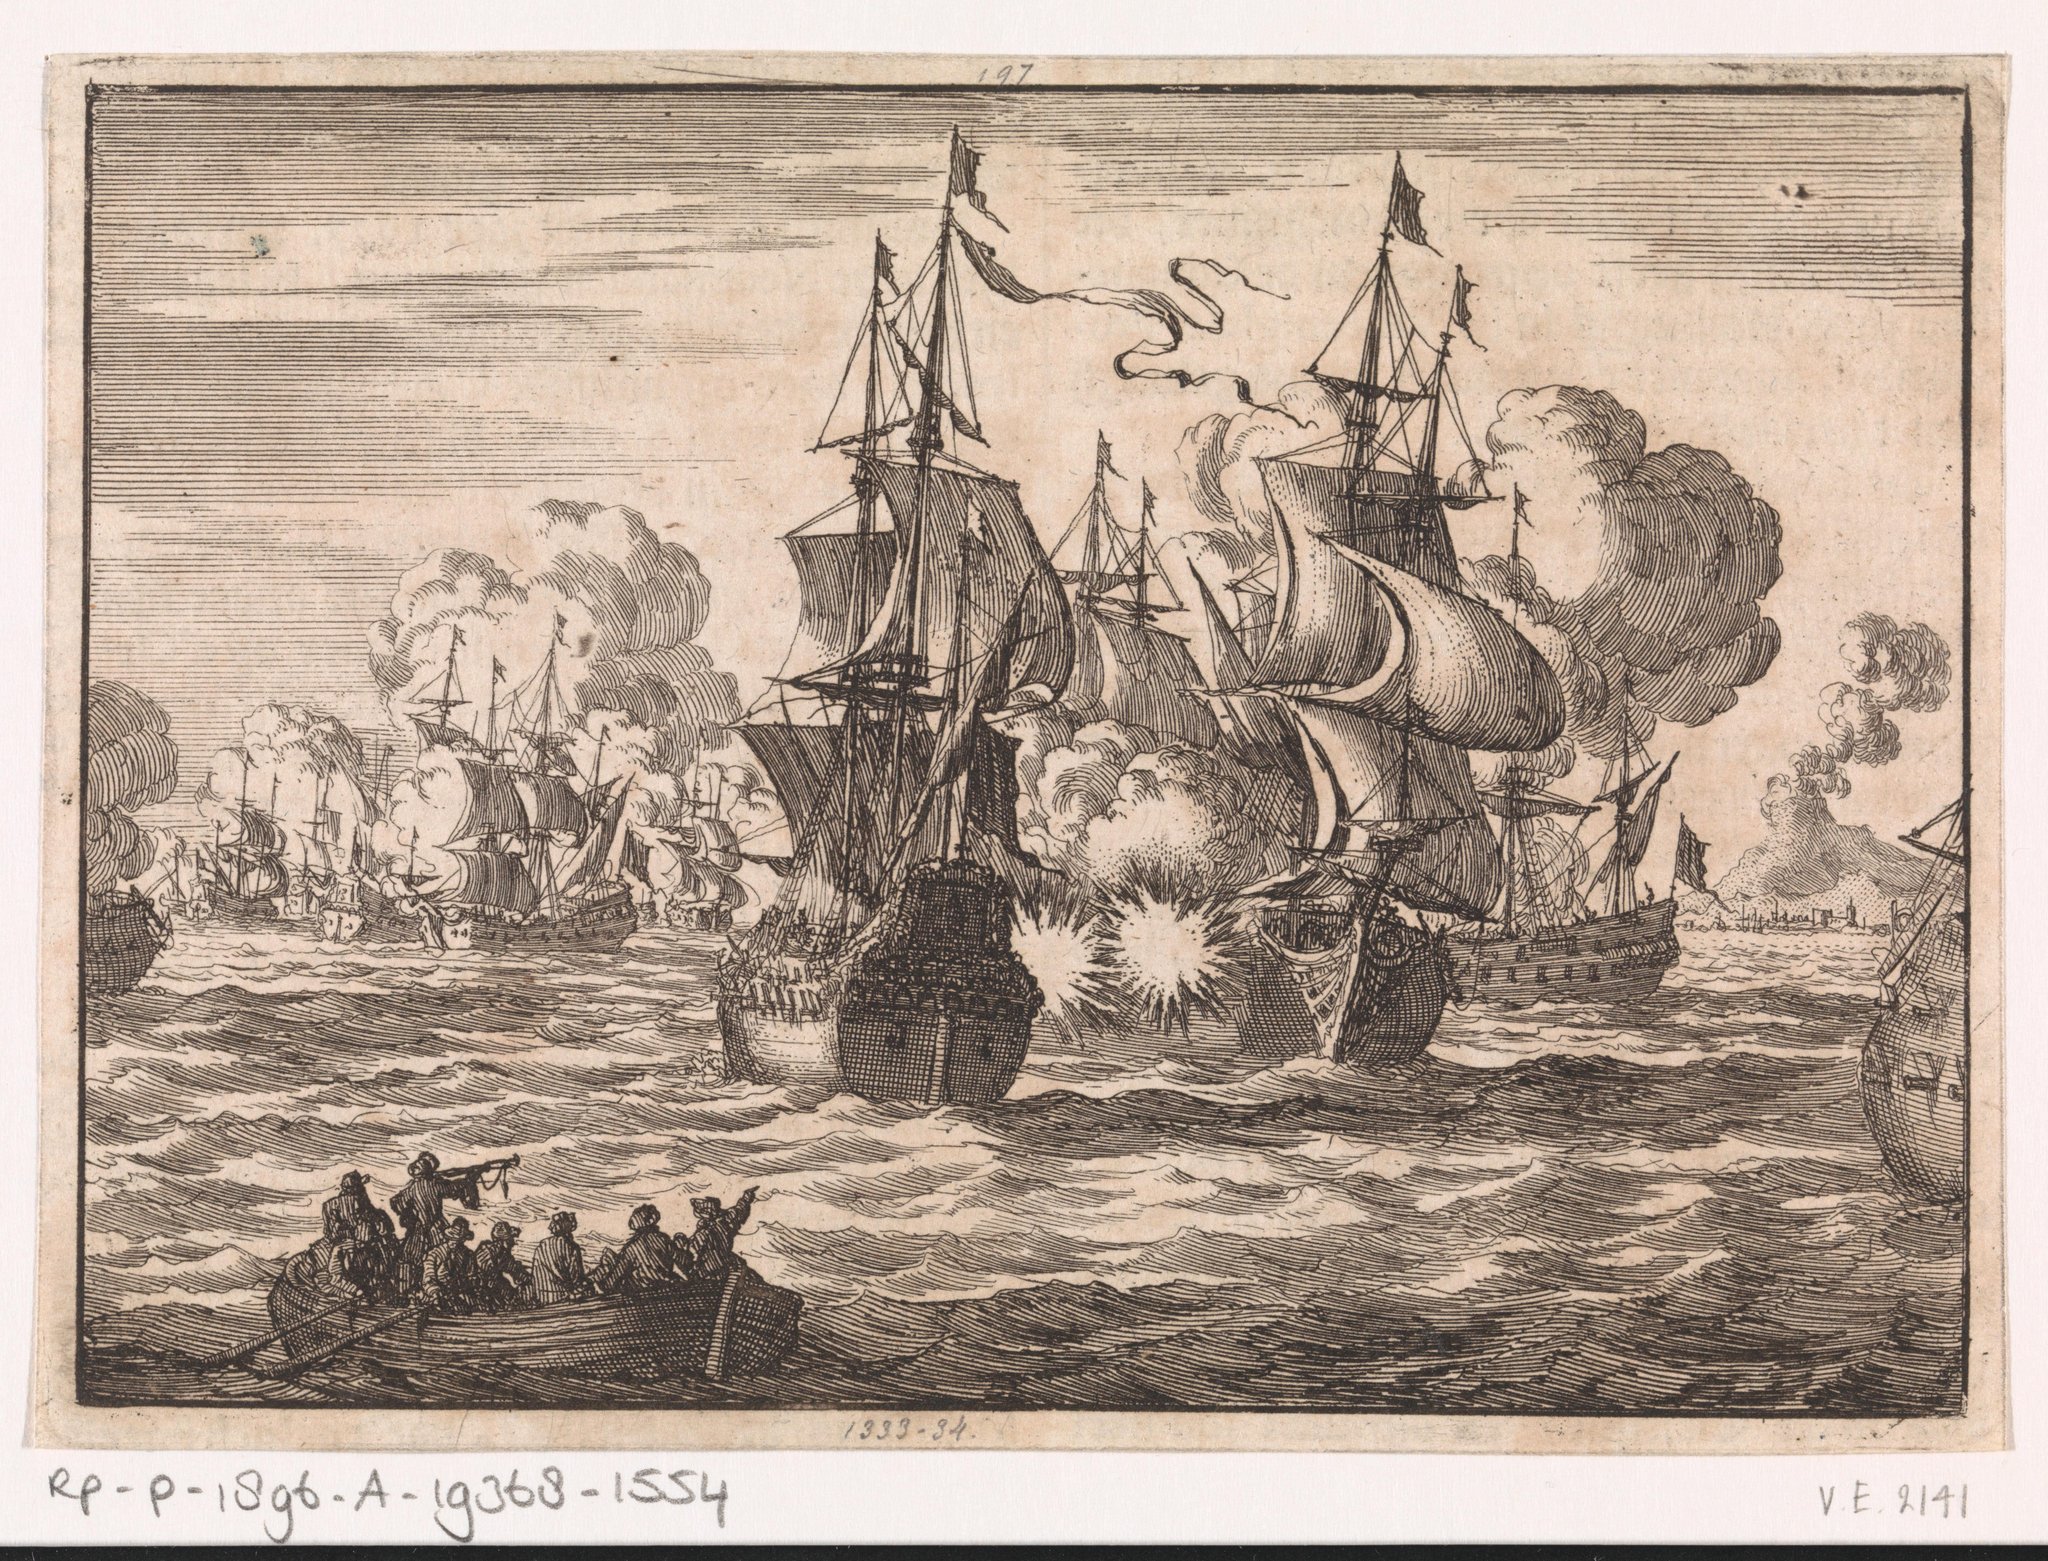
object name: print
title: Zeeslag bij Messina, 1676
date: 1698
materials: paper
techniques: etching, letterpress printing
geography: amsterdam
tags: battle (+ naval force)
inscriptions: collector's mark: Lugt 2228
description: Illustratie uit: Gottfried, Johann Ludwig. Historische kronyck; vervattende een (...) beschrijvingh der aldergedenckwaerdigste geschiedenissen des weerelds, van den aenvangh der scheppingh tot (...) 1576 (2 delen). Leiden: Pieter van der Aa, 1698, dl. II, p. 1333.